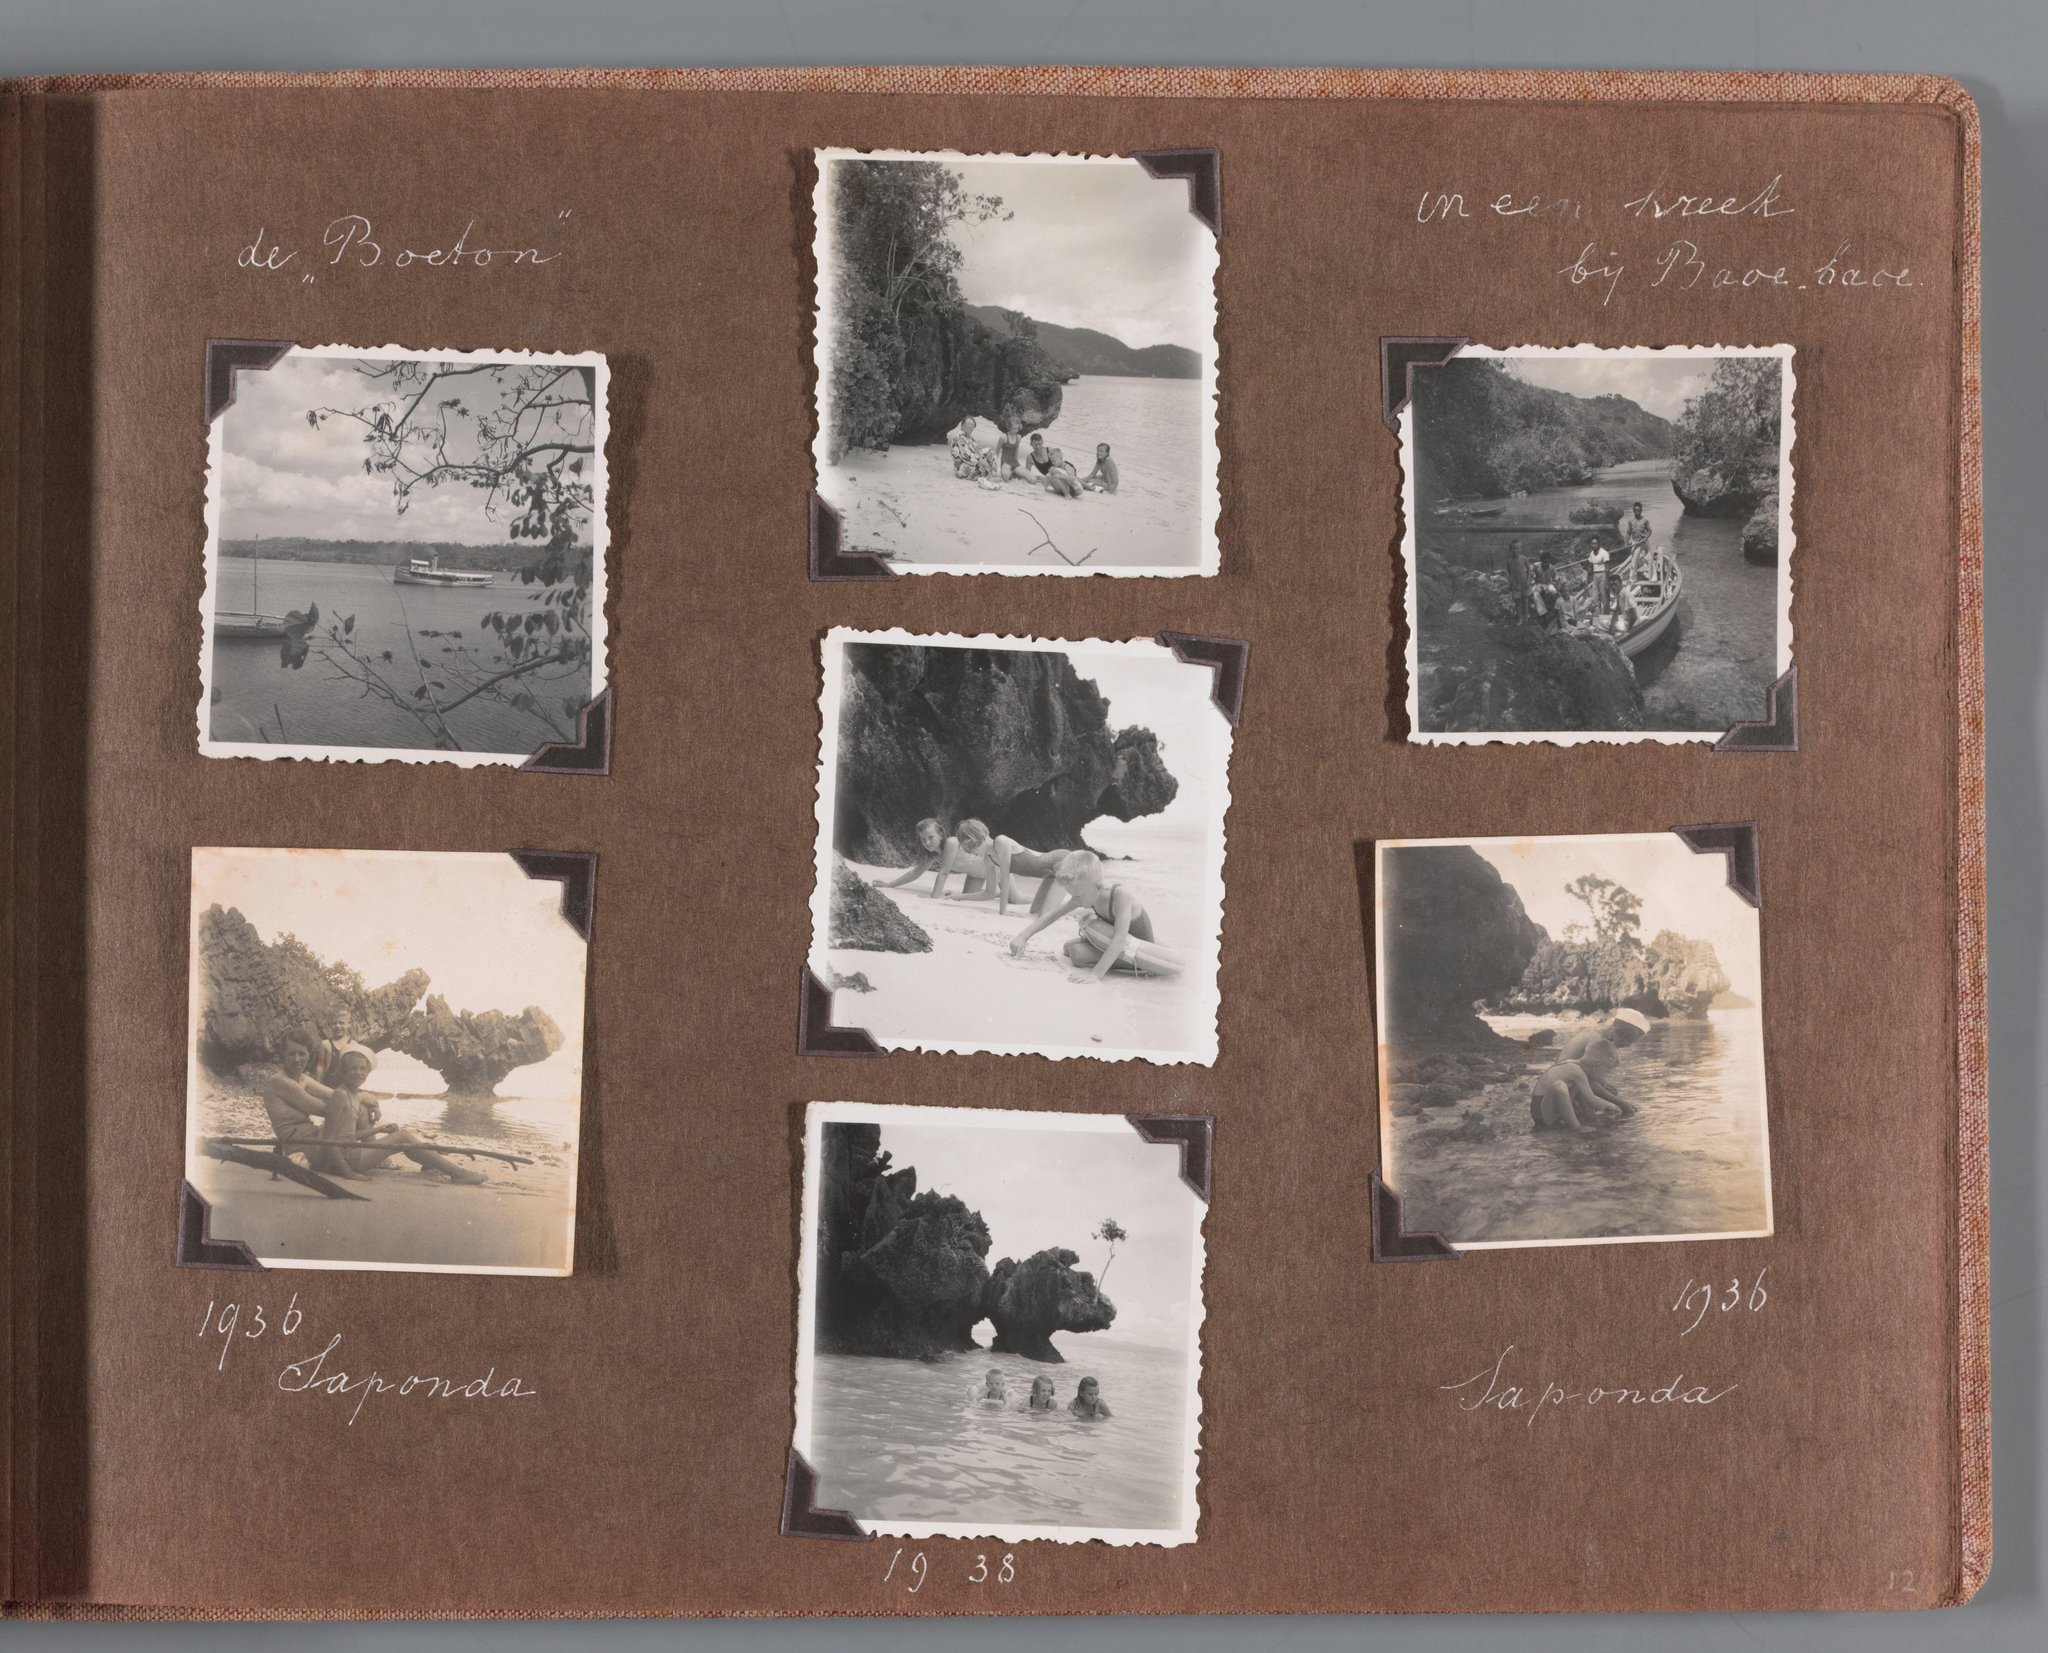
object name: photograph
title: Famileuitstapjes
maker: Anonymous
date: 1936-1938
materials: cardboard, photographic support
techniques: gelatin silver print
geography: celebes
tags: r.h. vonk, family life, swimming (sport), outing, pleasure trip, coast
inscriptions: inscription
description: Albumblad met zeven foto's van verschillende uitjes van de familie Vonk naar de kust in 1936 en 1938. Onderdeel van het fotoalbum van familie Vonk op Zuid-Celebes.